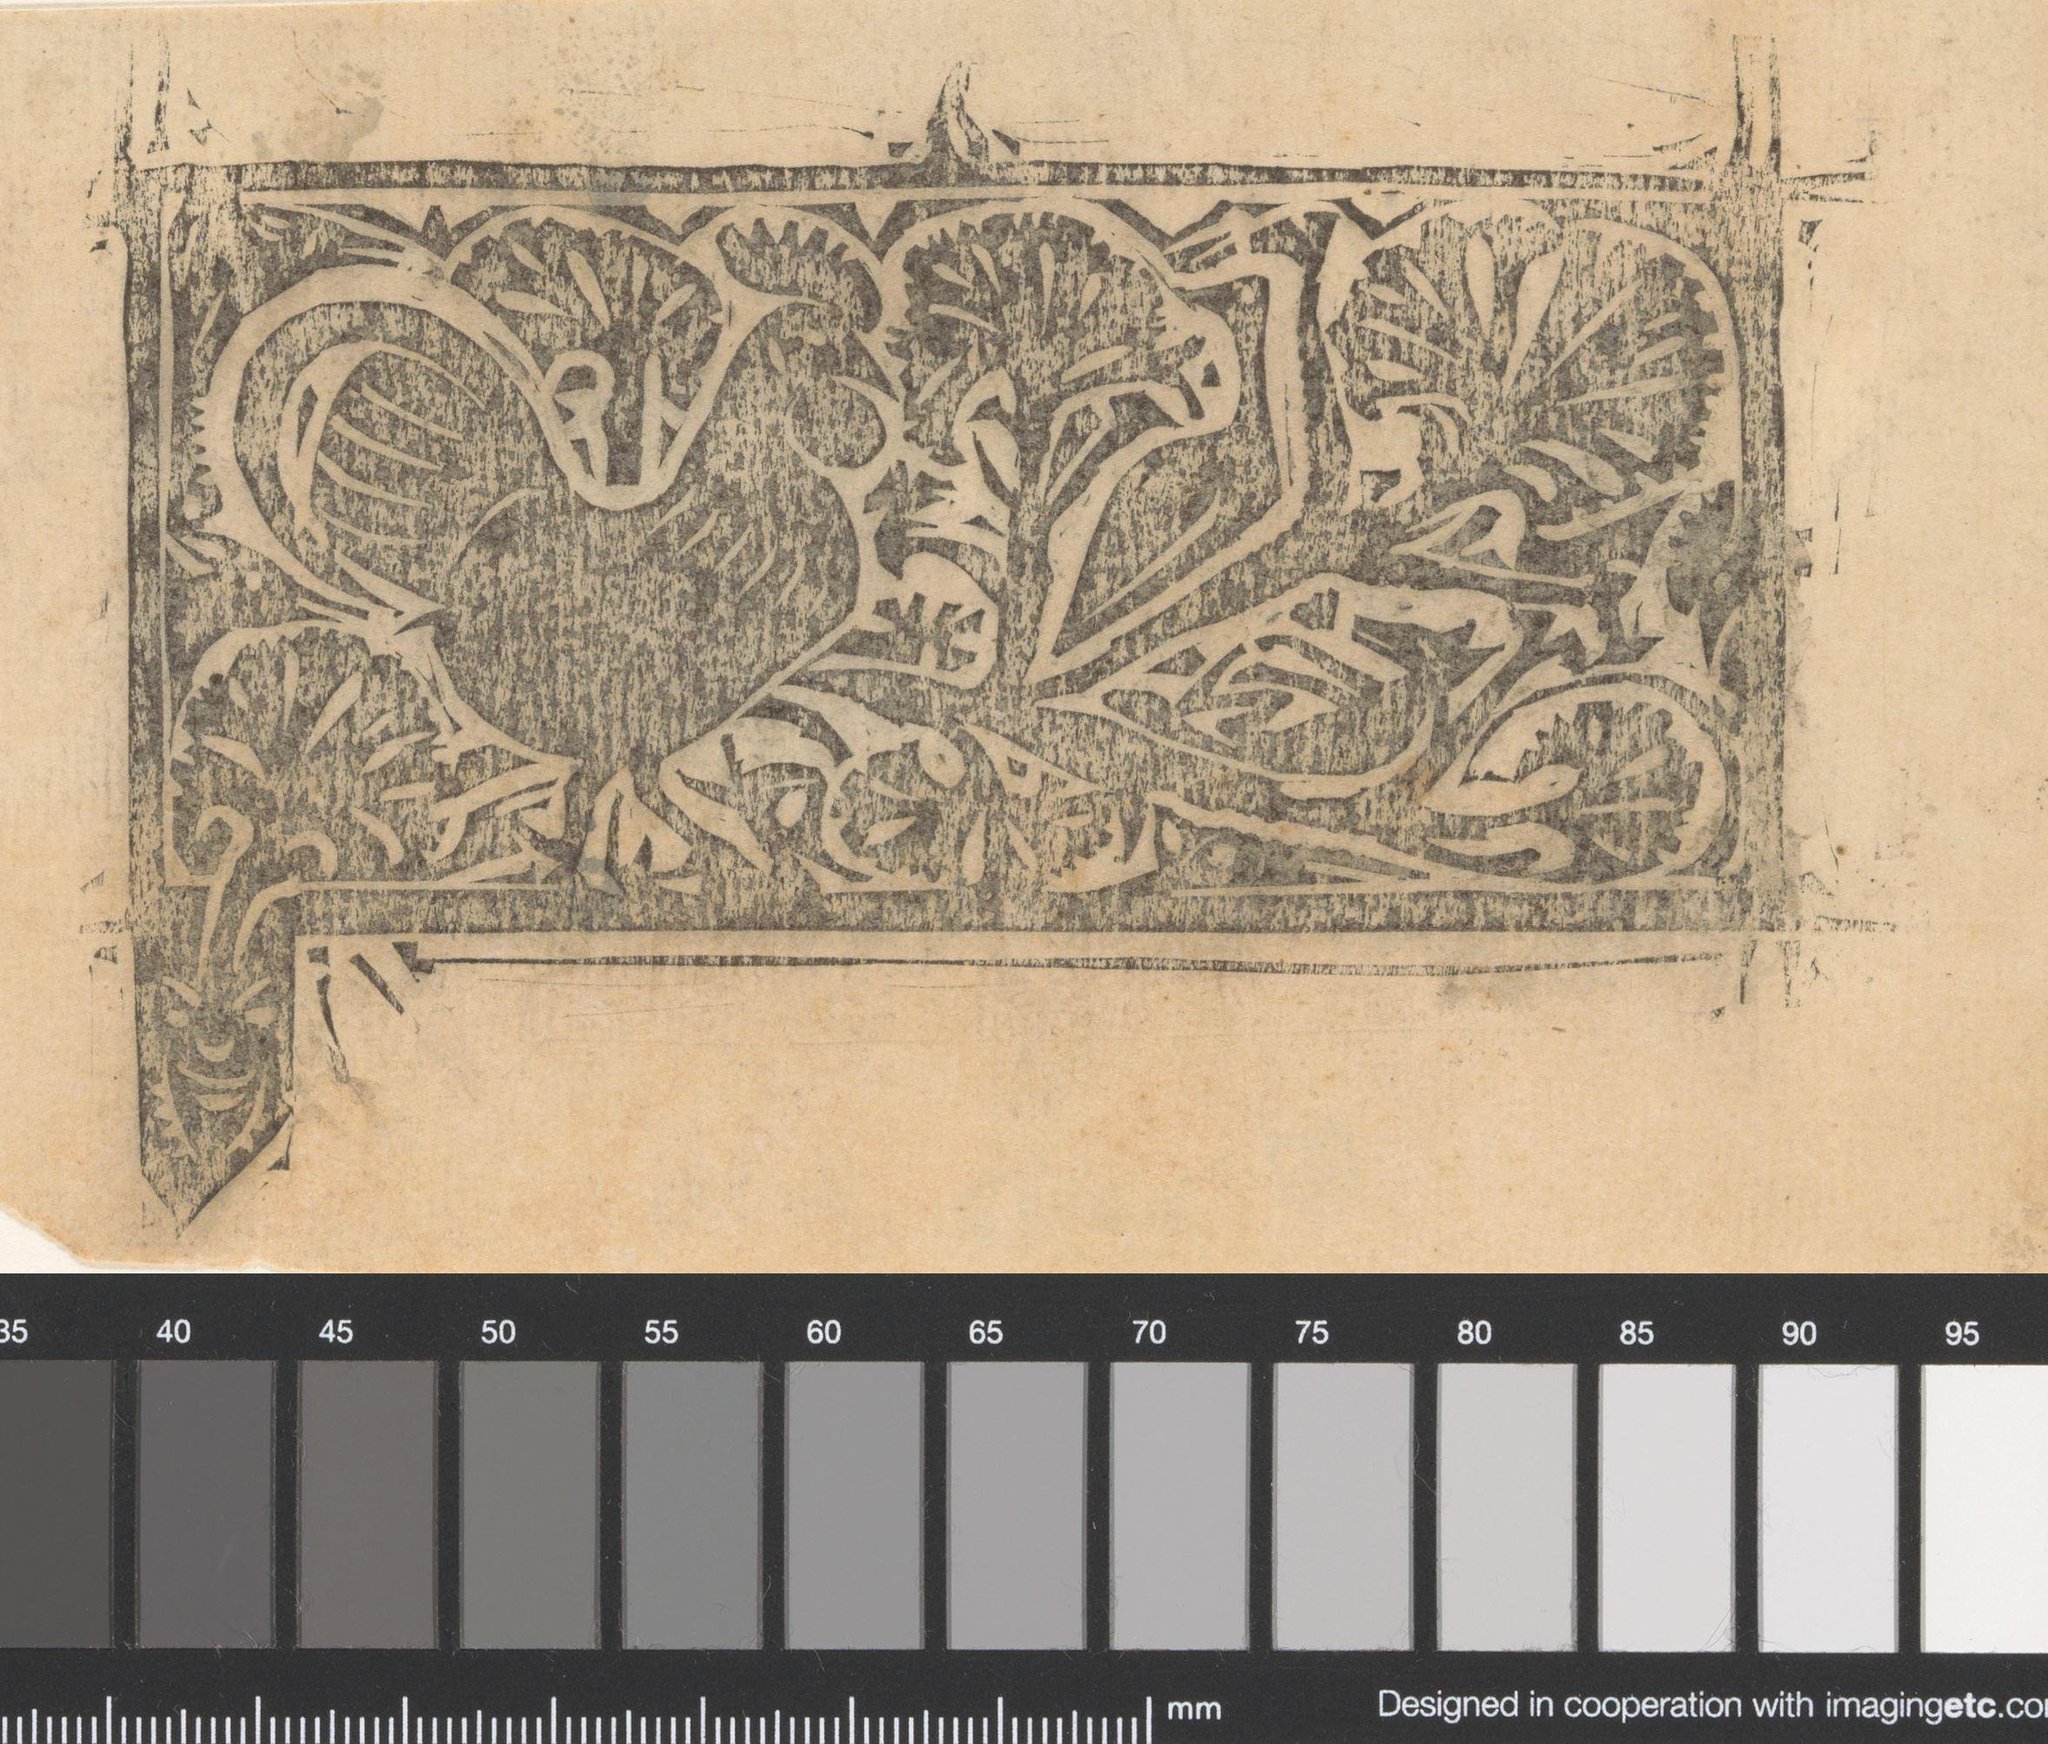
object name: print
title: Titelhoofd met een haan en dieren verborgen in struiken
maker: gerrit willem dijsselhof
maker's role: designer, draughtsman, print maker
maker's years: 1866-1924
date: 1893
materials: paper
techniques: woodcut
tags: animals, fowl (cock, hen, chicken, etc.) (+ male animal)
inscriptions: collector's mark: Lugt 2760, collector's mark: Lugt 2228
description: Prent gebruikt voor: Crane, Walter [vertaling: Veth, Jan]. Kunst en samenleving. Amsterdam: Scheltema & Holkema’s Boekhandel, 1893.